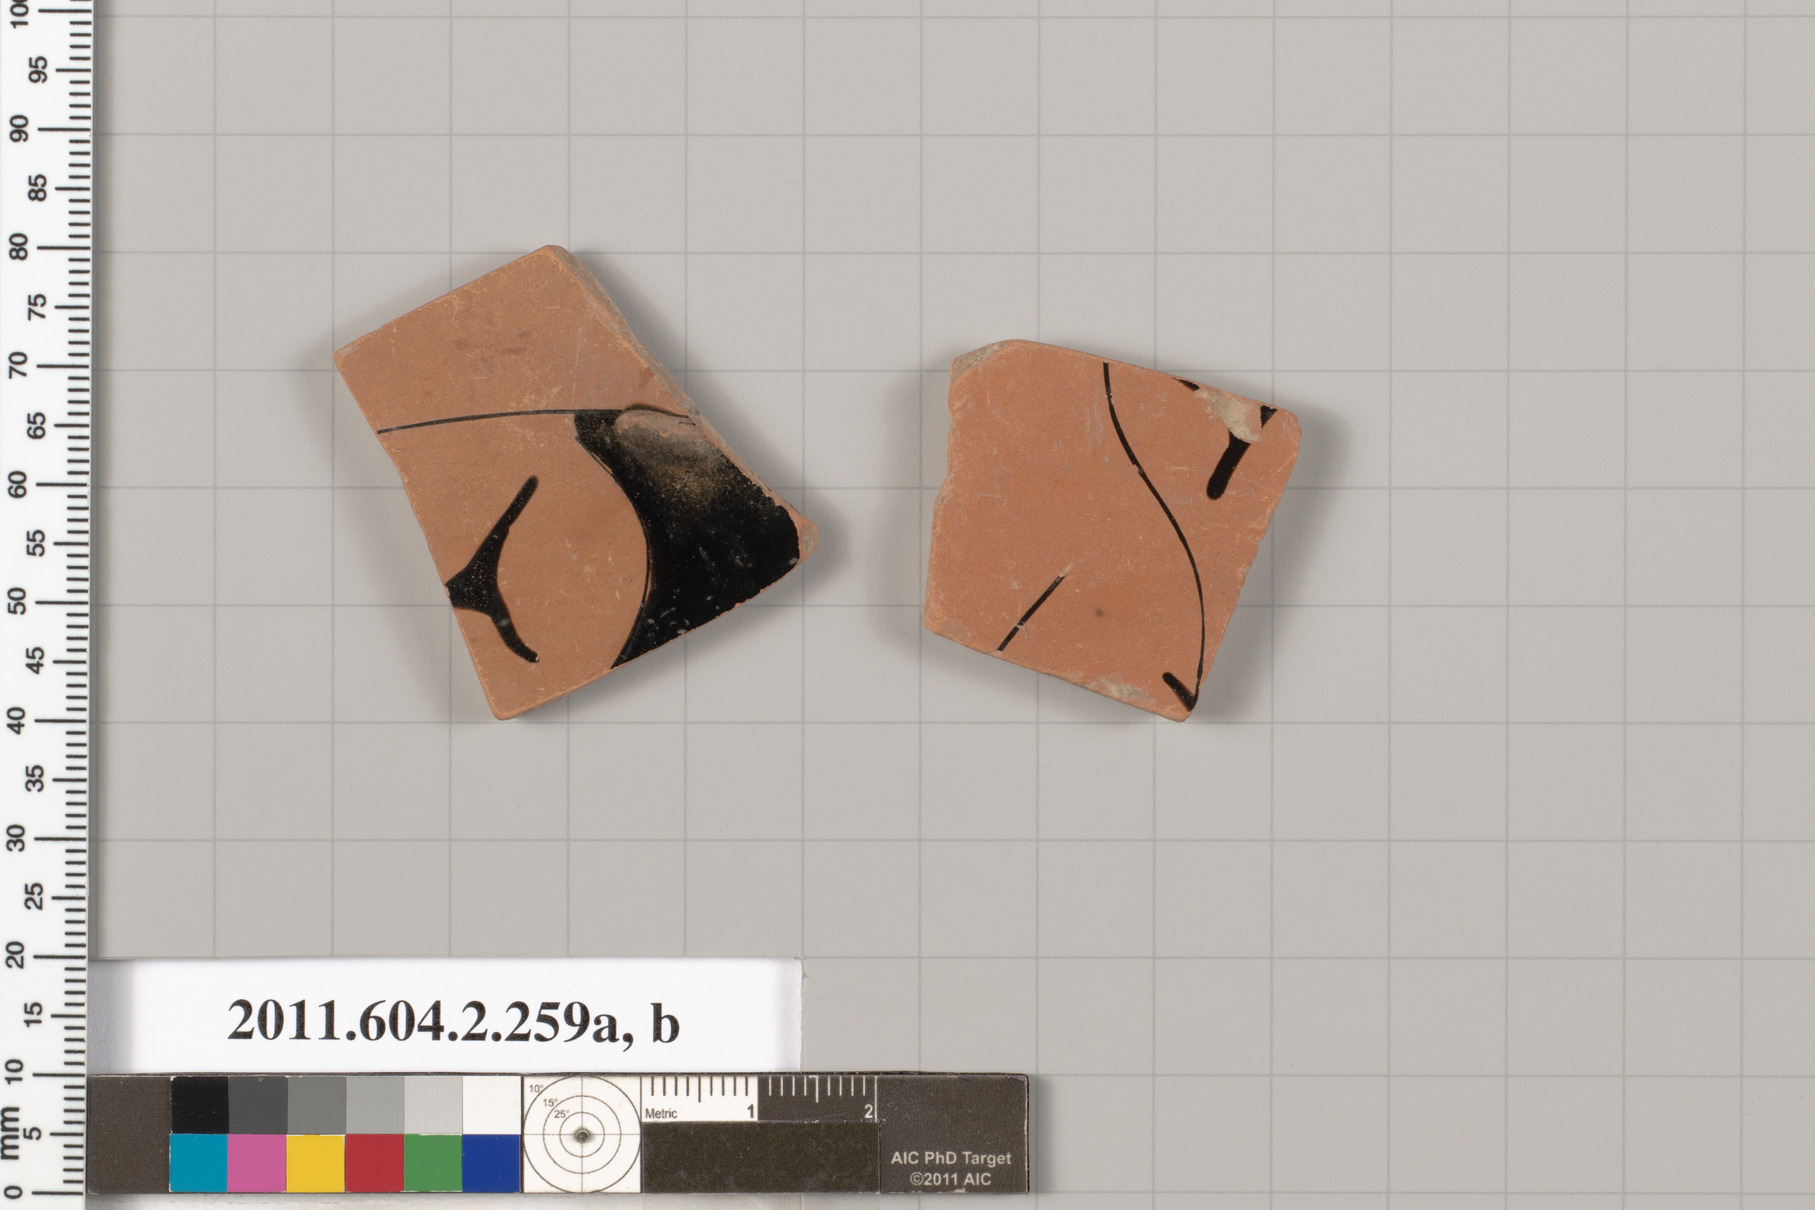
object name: stamnos fragment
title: Terracotta fragments of a stamnos (jar)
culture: greek, attic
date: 490-470 BCE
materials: terracotta